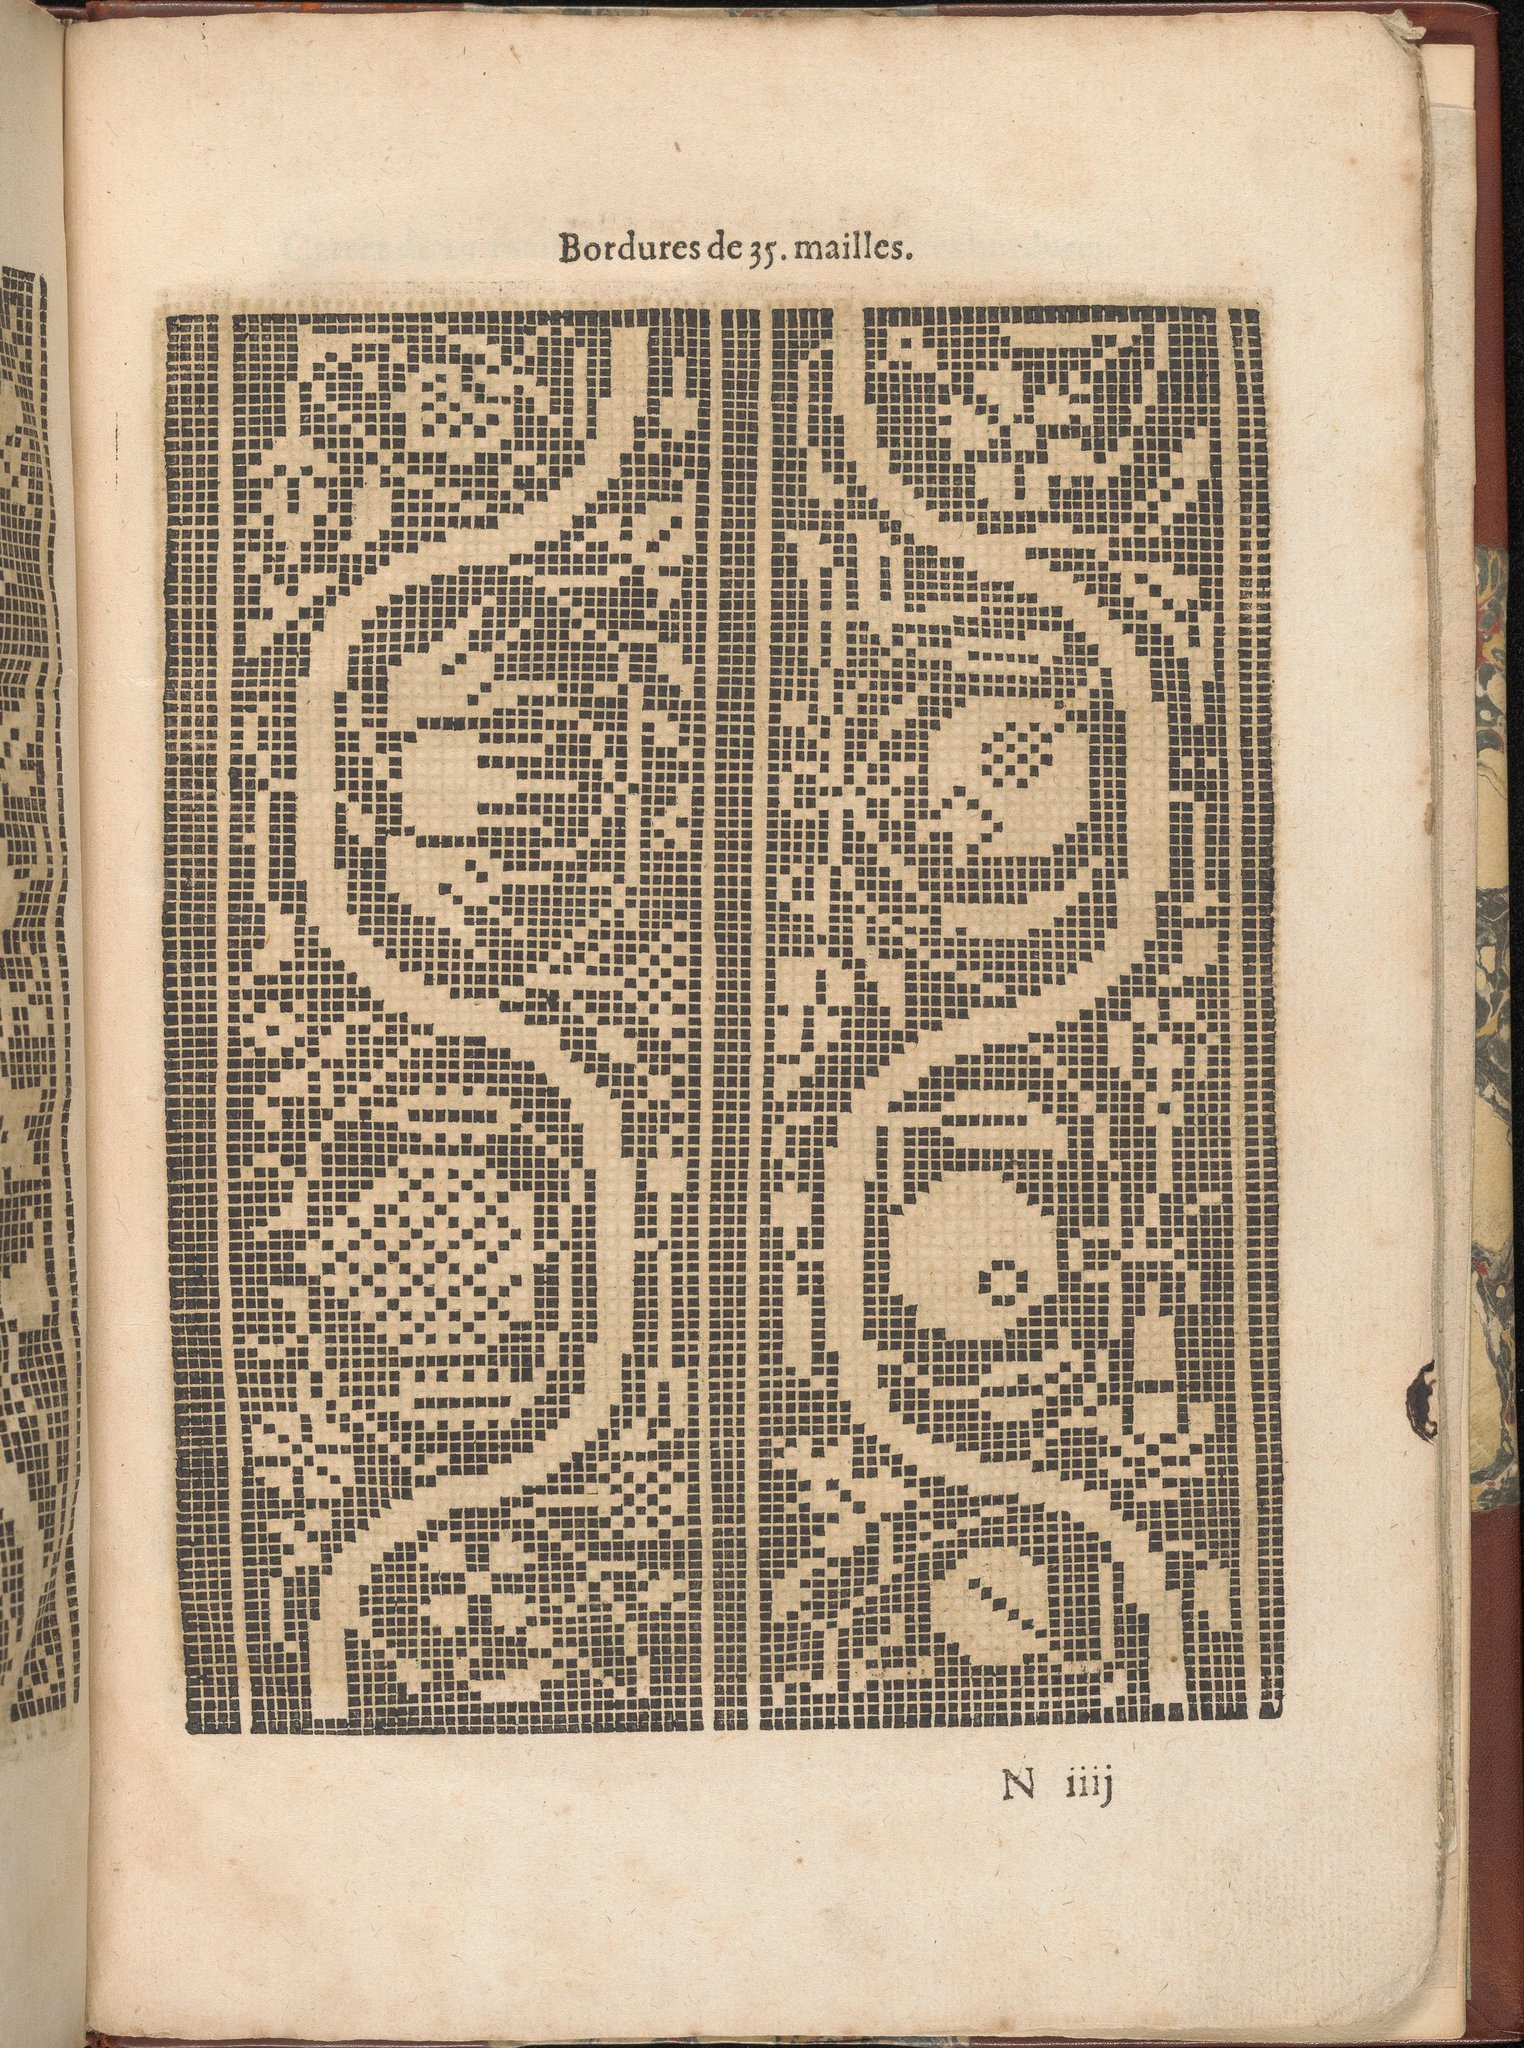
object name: book print ornament architecture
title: Les Secondes Oeuvres, et Subtiles Inventions De Lingerie du Seigneur Federic de Vinciolo Venitien, page 52 (recto)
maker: federico de vinciolo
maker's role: designer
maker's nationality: italian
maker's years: 1582-1599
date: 1603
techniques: woodcut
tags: fruit,flowers